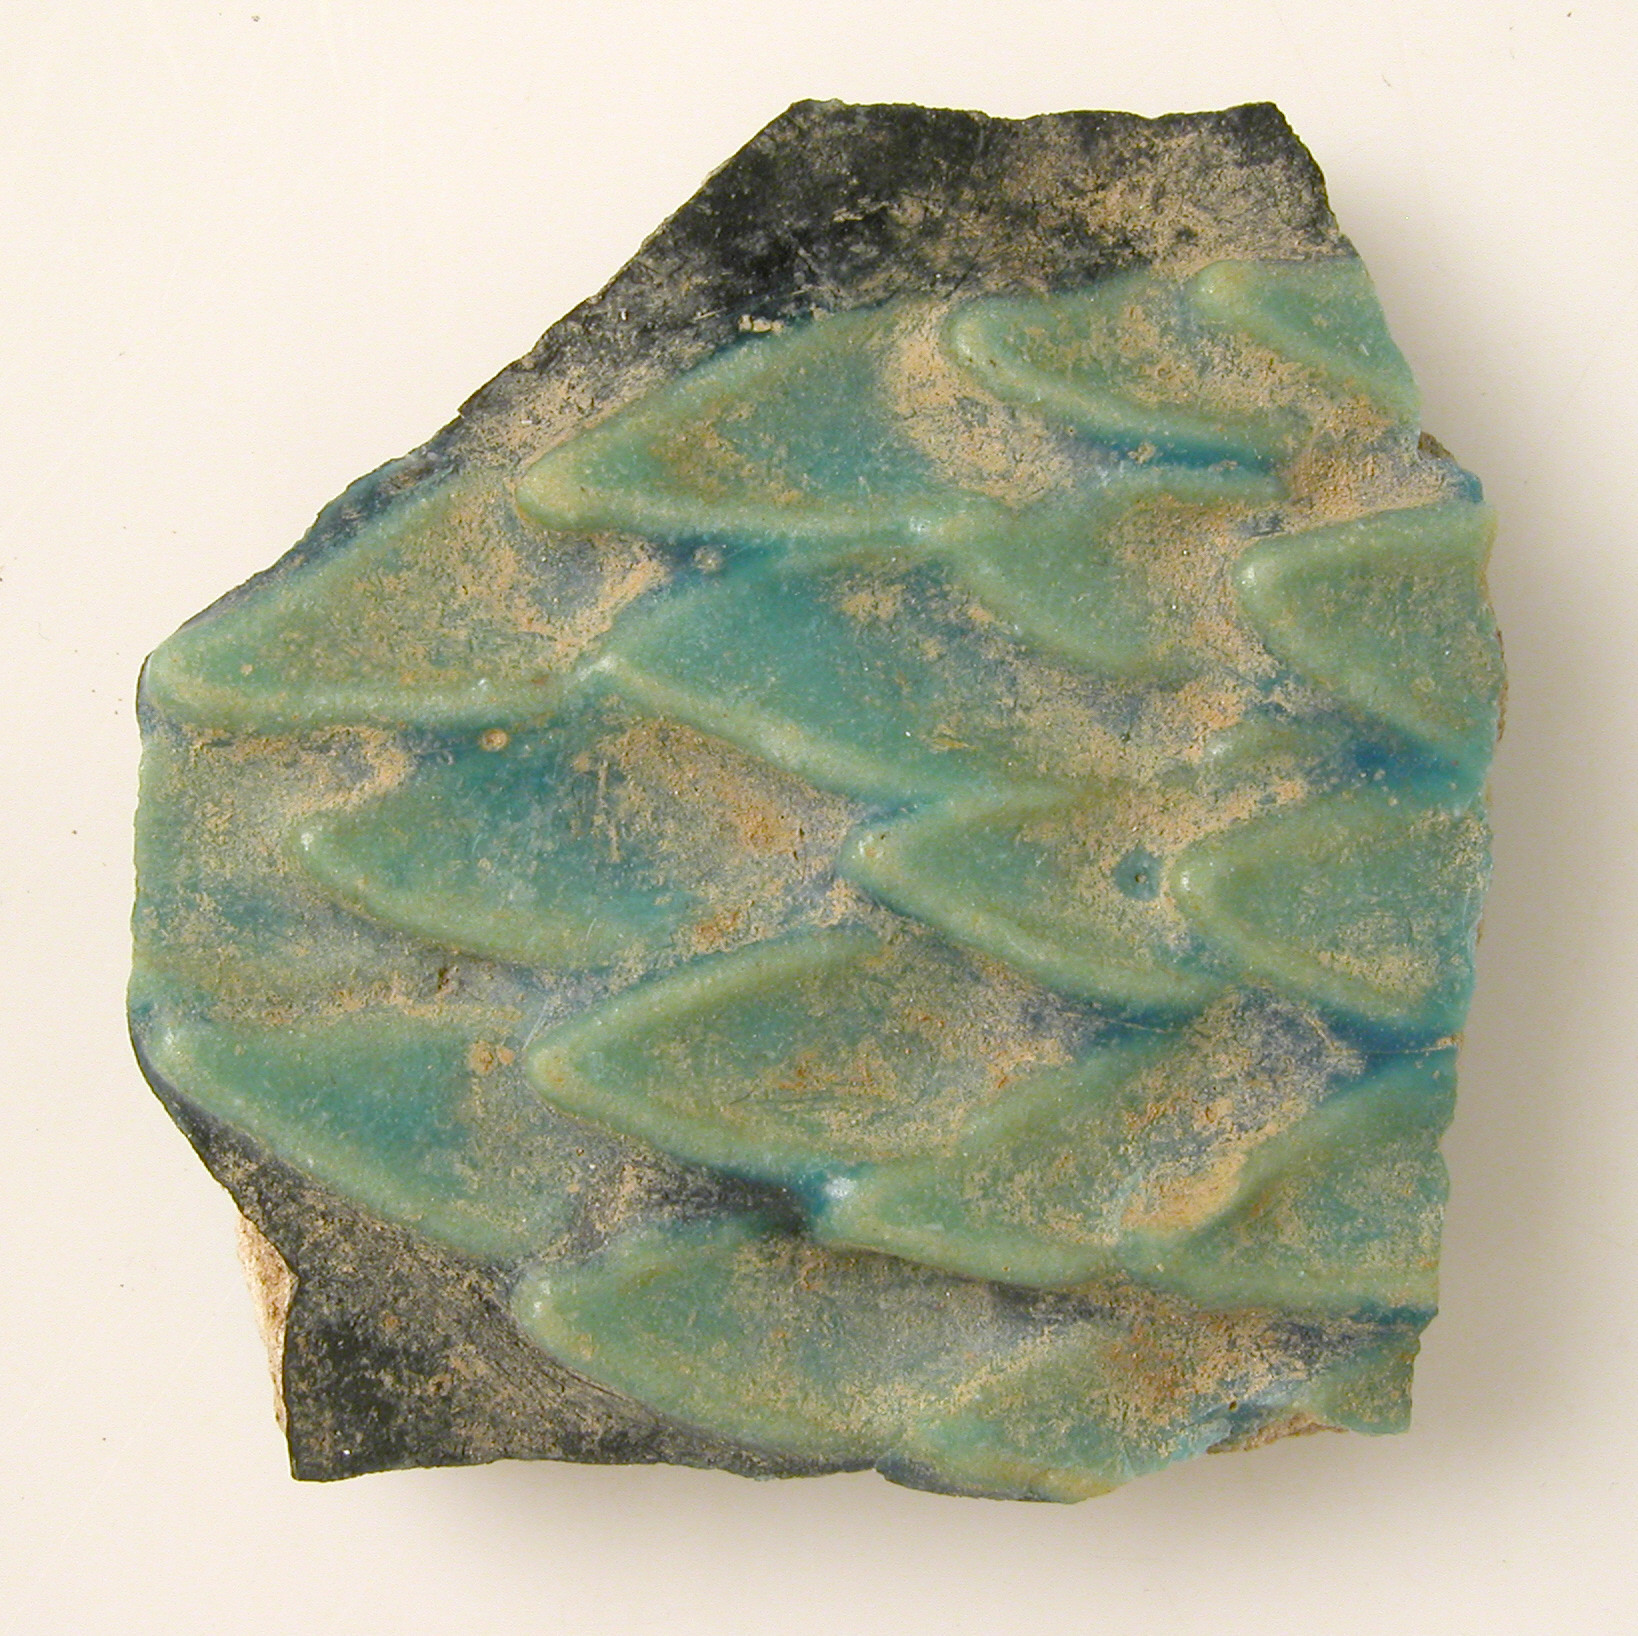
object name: fragment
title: Pottery Fragment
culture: coptic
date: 301-700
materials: earthenware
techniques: glazing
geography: egypt